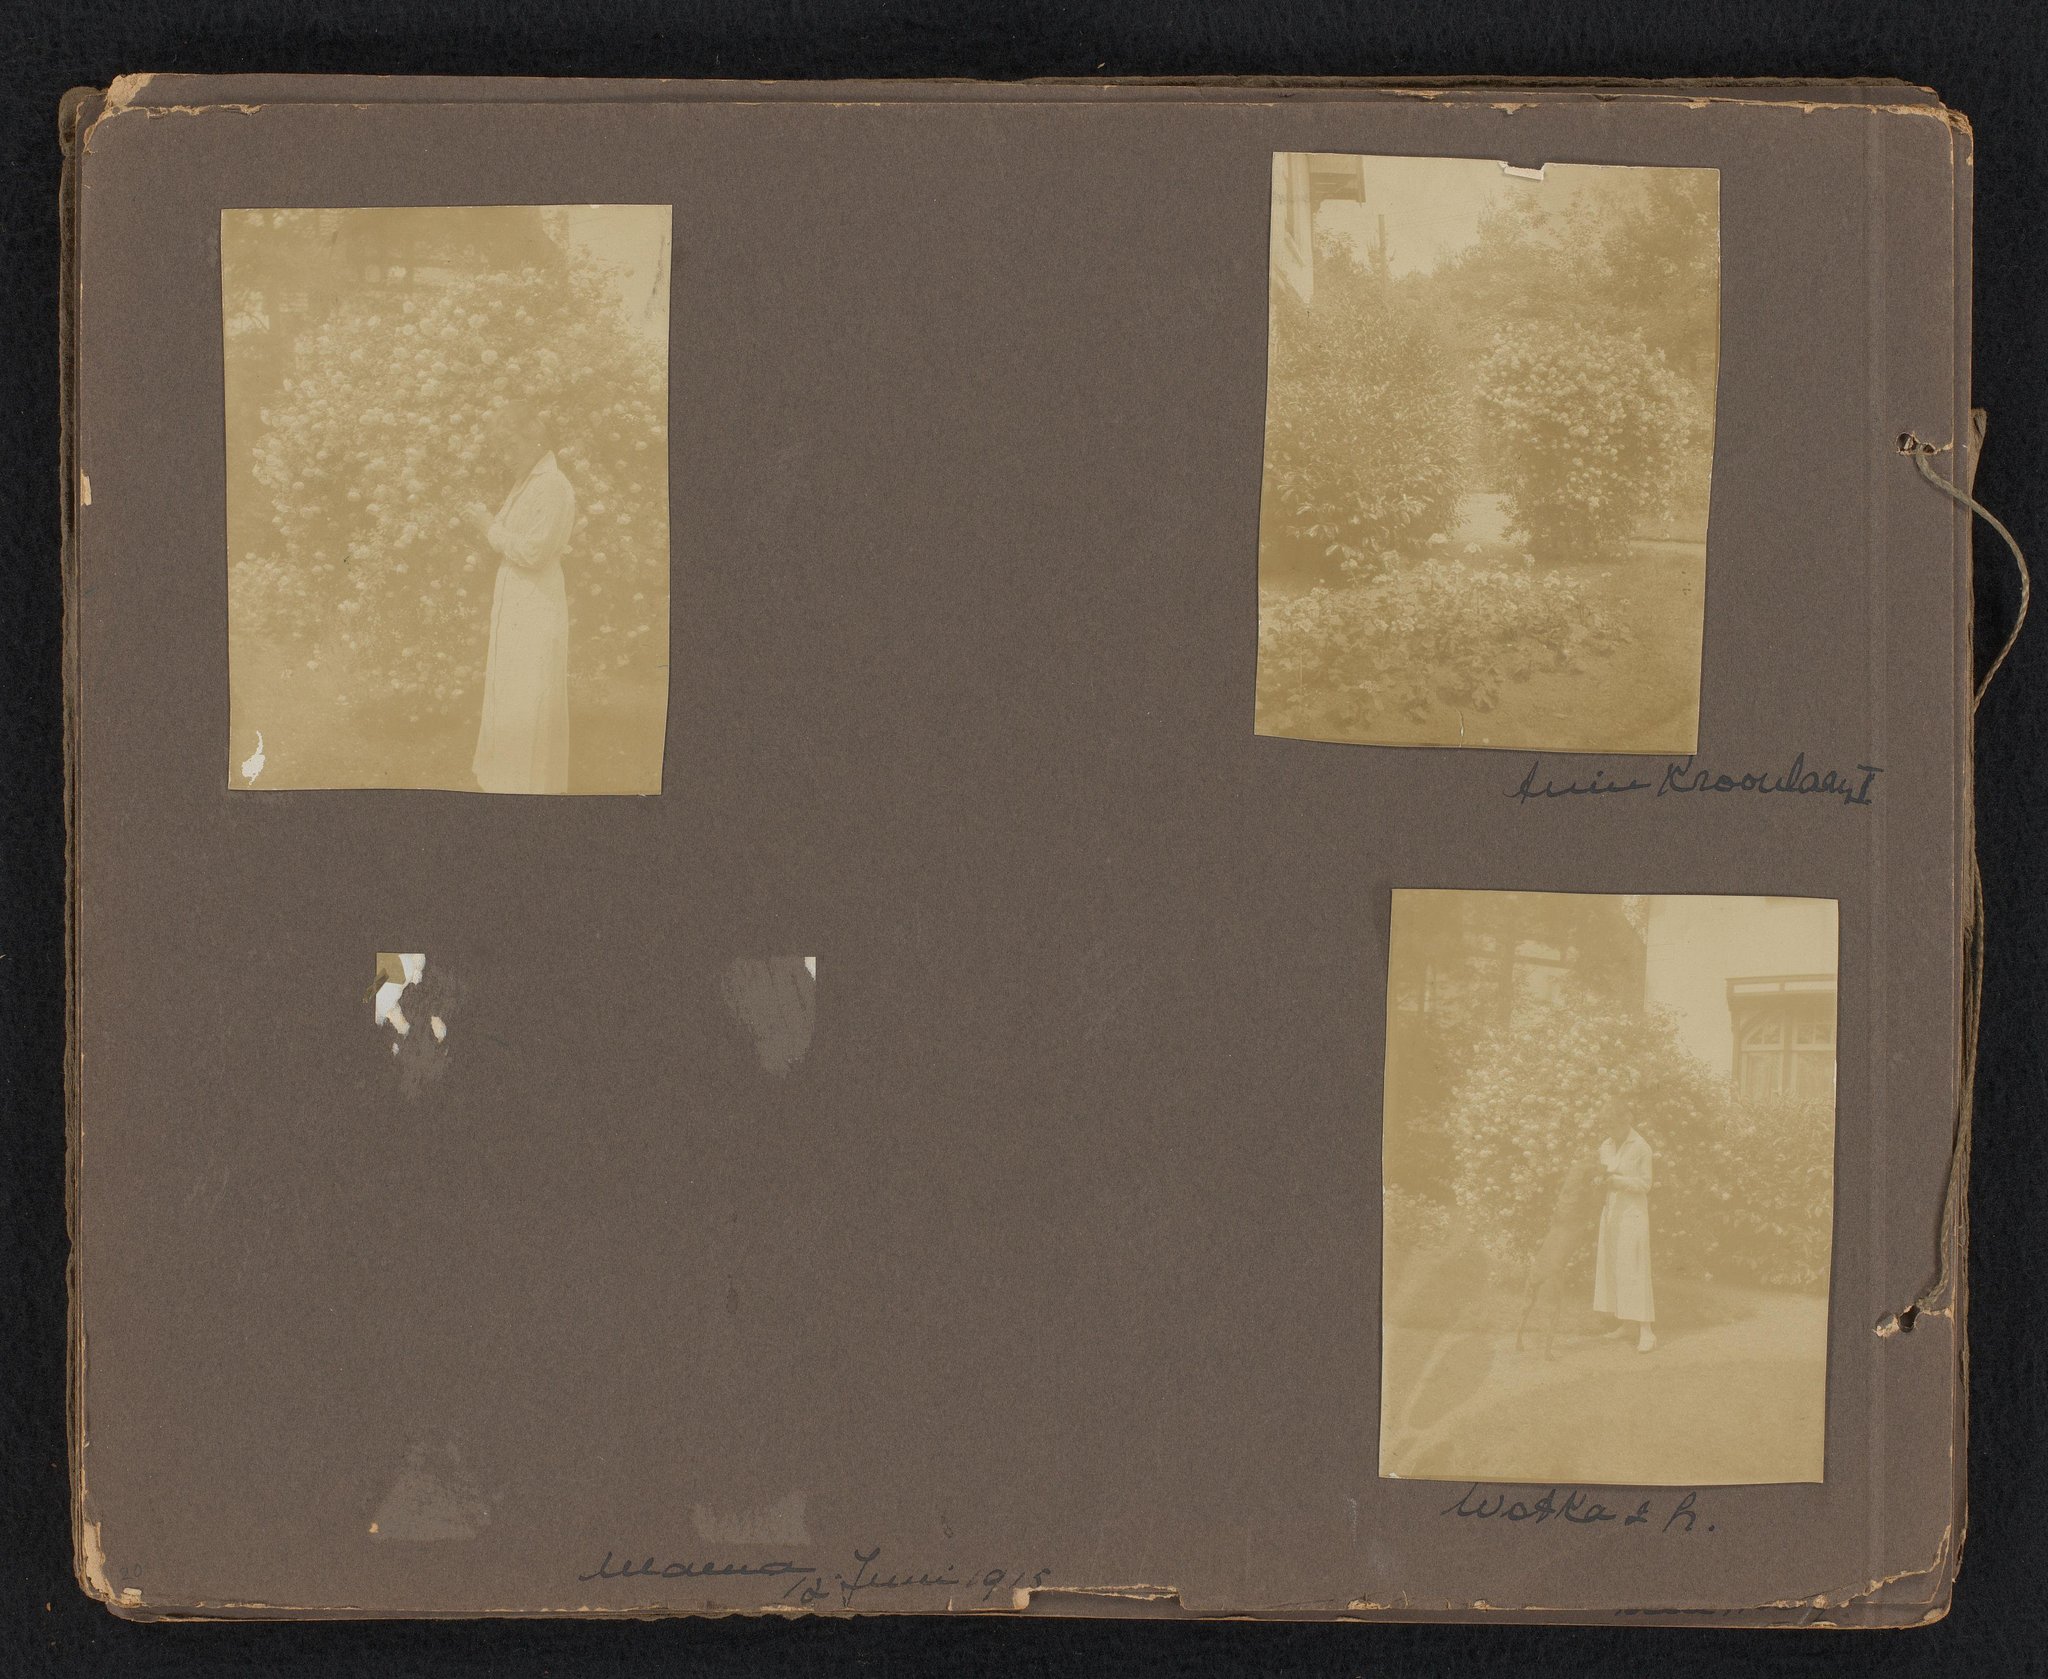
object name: photograph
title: Drie foto's van een vrouw bij bloeiende struiken in de tuin van Kroonlaan 1, Hilversum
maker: carolina frederika onnen (lien/loen)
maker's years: 1896-1983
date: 1915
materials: paper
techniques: gelatin silver print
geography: hilversum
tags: garden, dog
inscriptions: inscription: ‘Wotka & H.’, inscription: ‘Mama 12 Juni 1915’, inscription: ‘huize Kroonlaan I’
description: Deze foto's maken deel uit van een album.